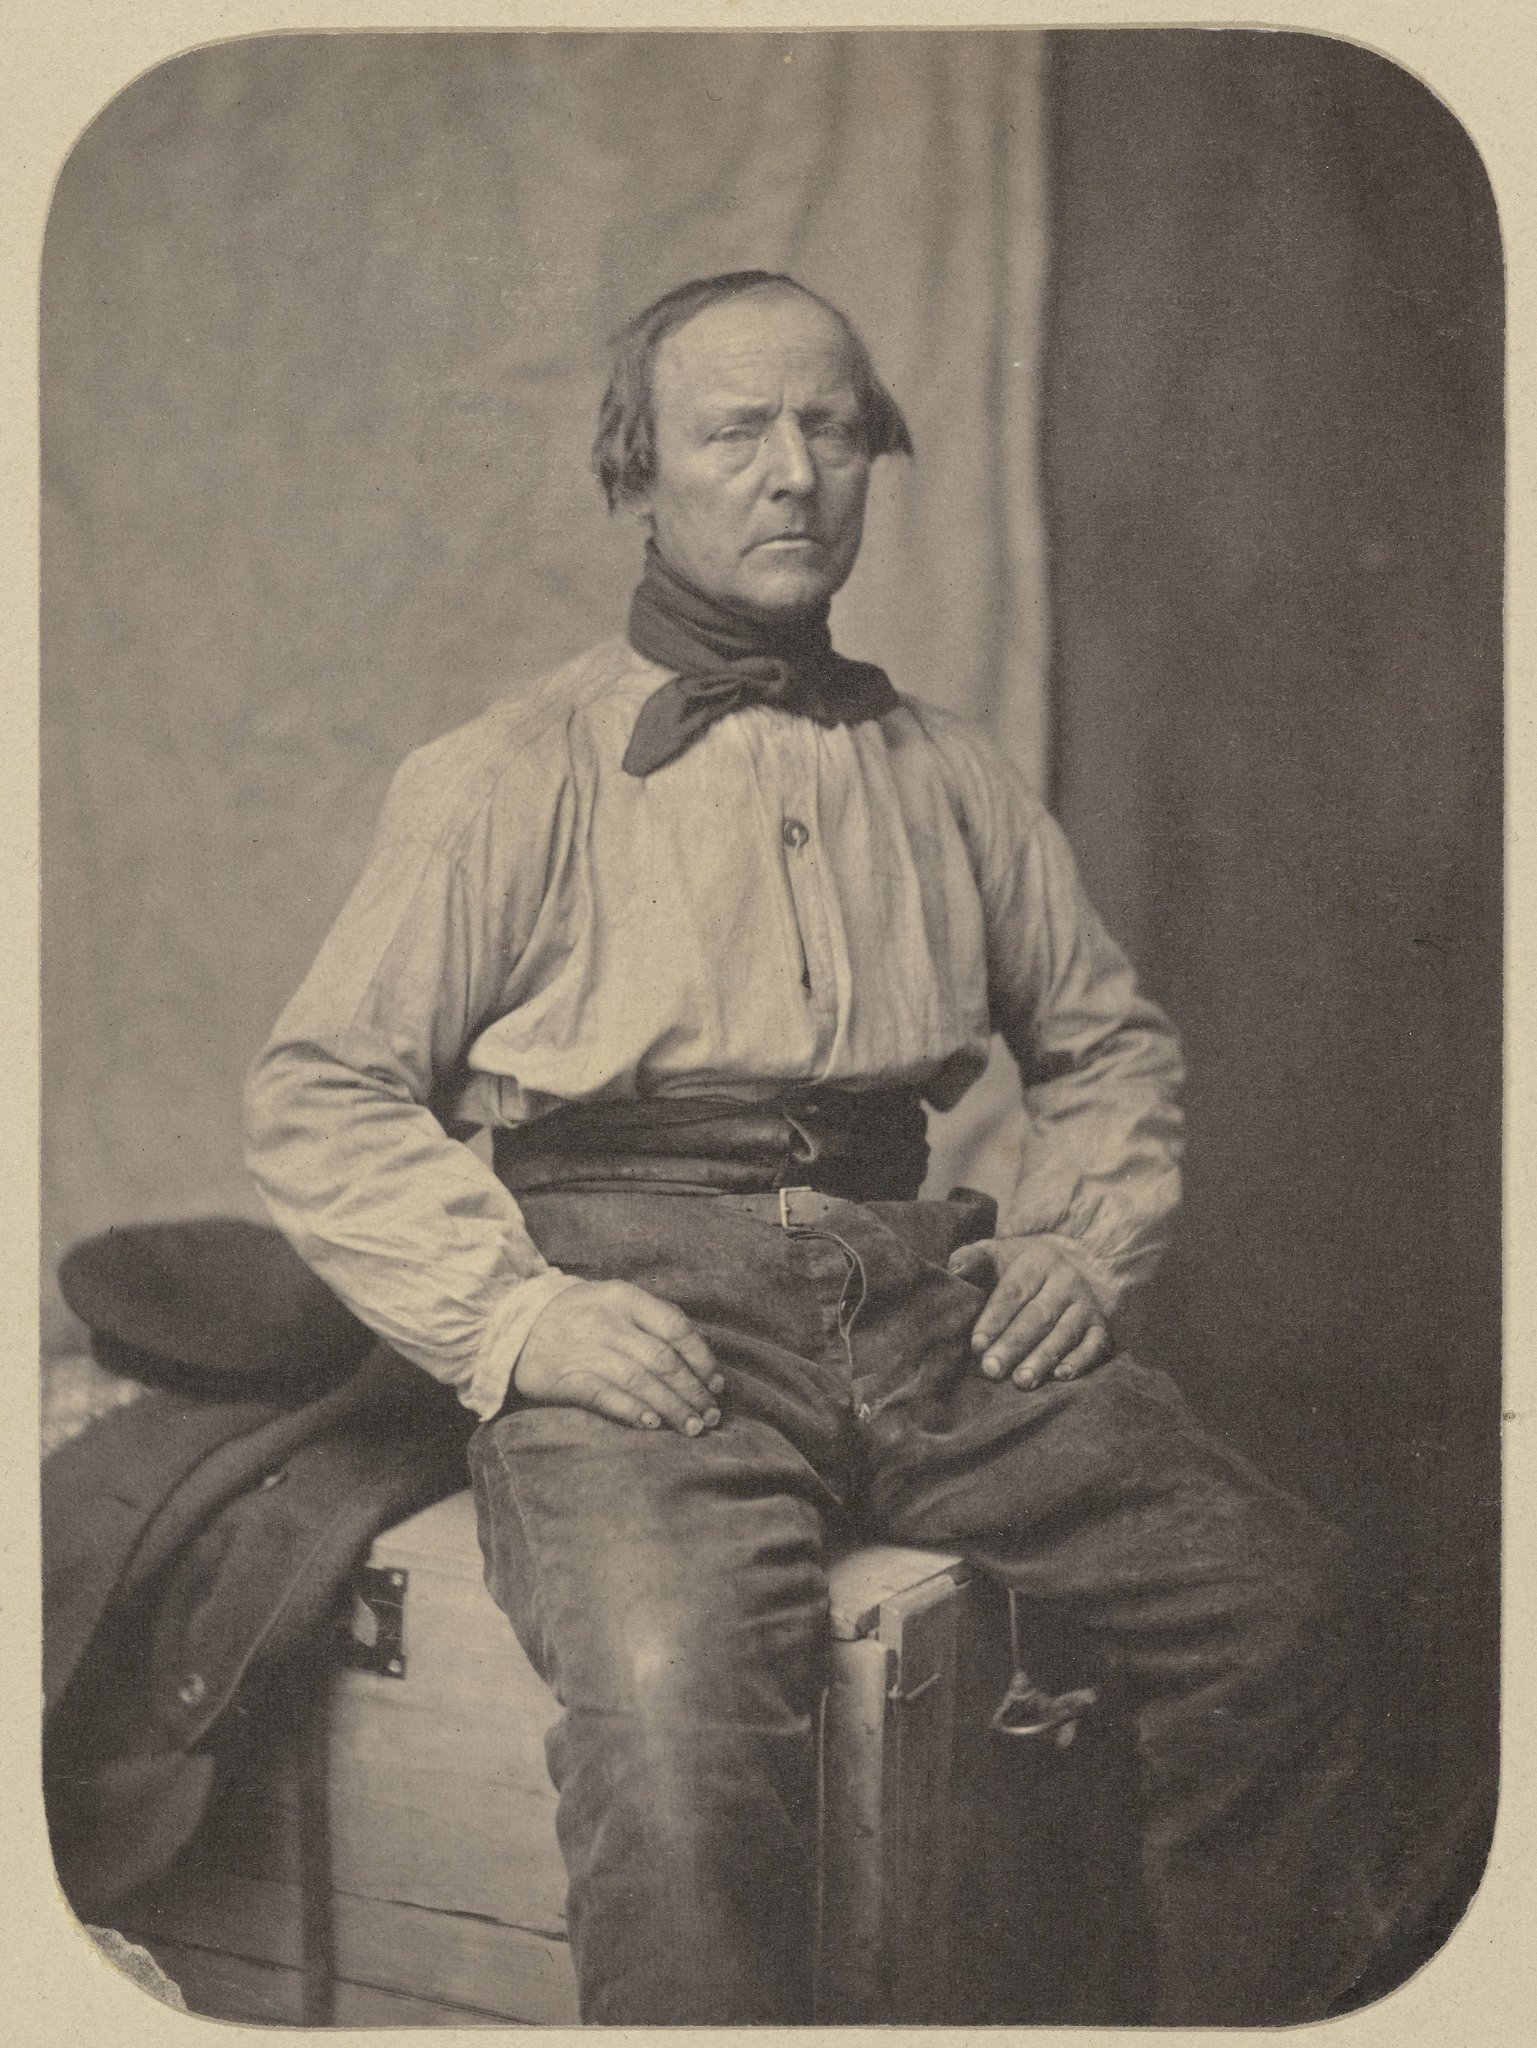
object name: photograph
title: Portret van een werkman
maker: eduard isaac asser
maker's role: amateurfotograaf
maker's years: 1809-1894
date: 1854-1855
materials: cardboard, paper, photographic support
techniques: salted paper print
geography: amsterdam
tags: historical persons